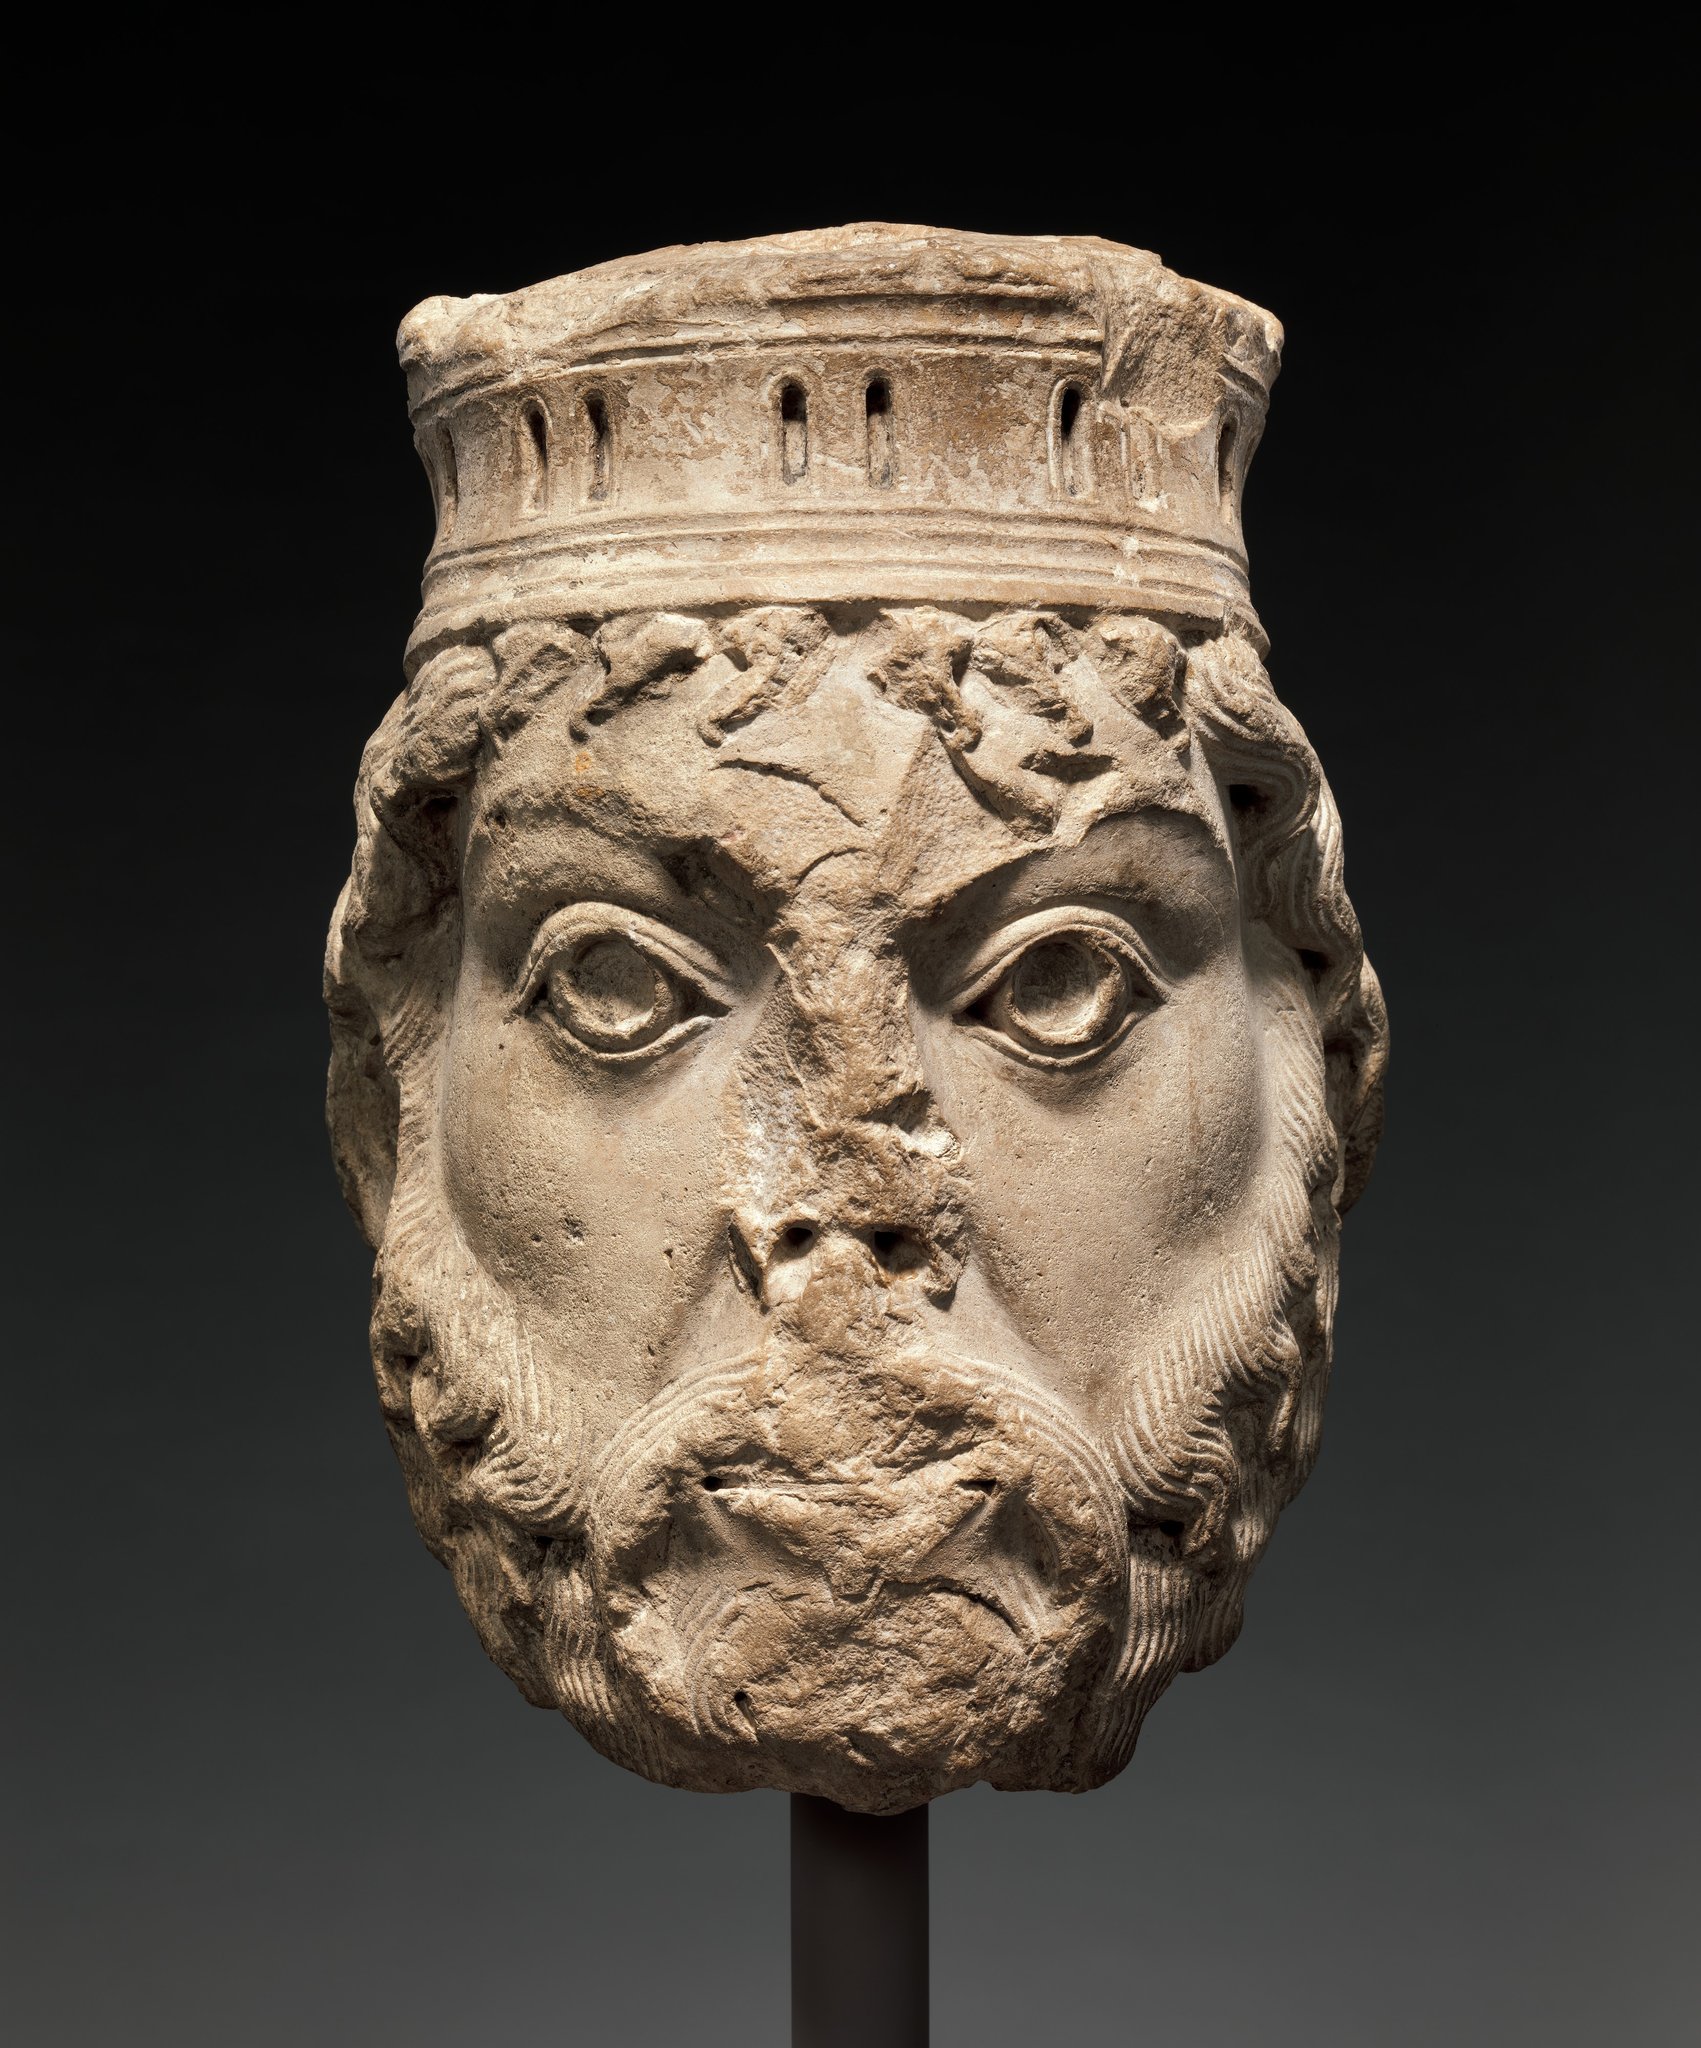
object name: statue head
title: Head of King David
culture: french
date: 1145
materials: limestone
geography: paris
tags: heads,men,david